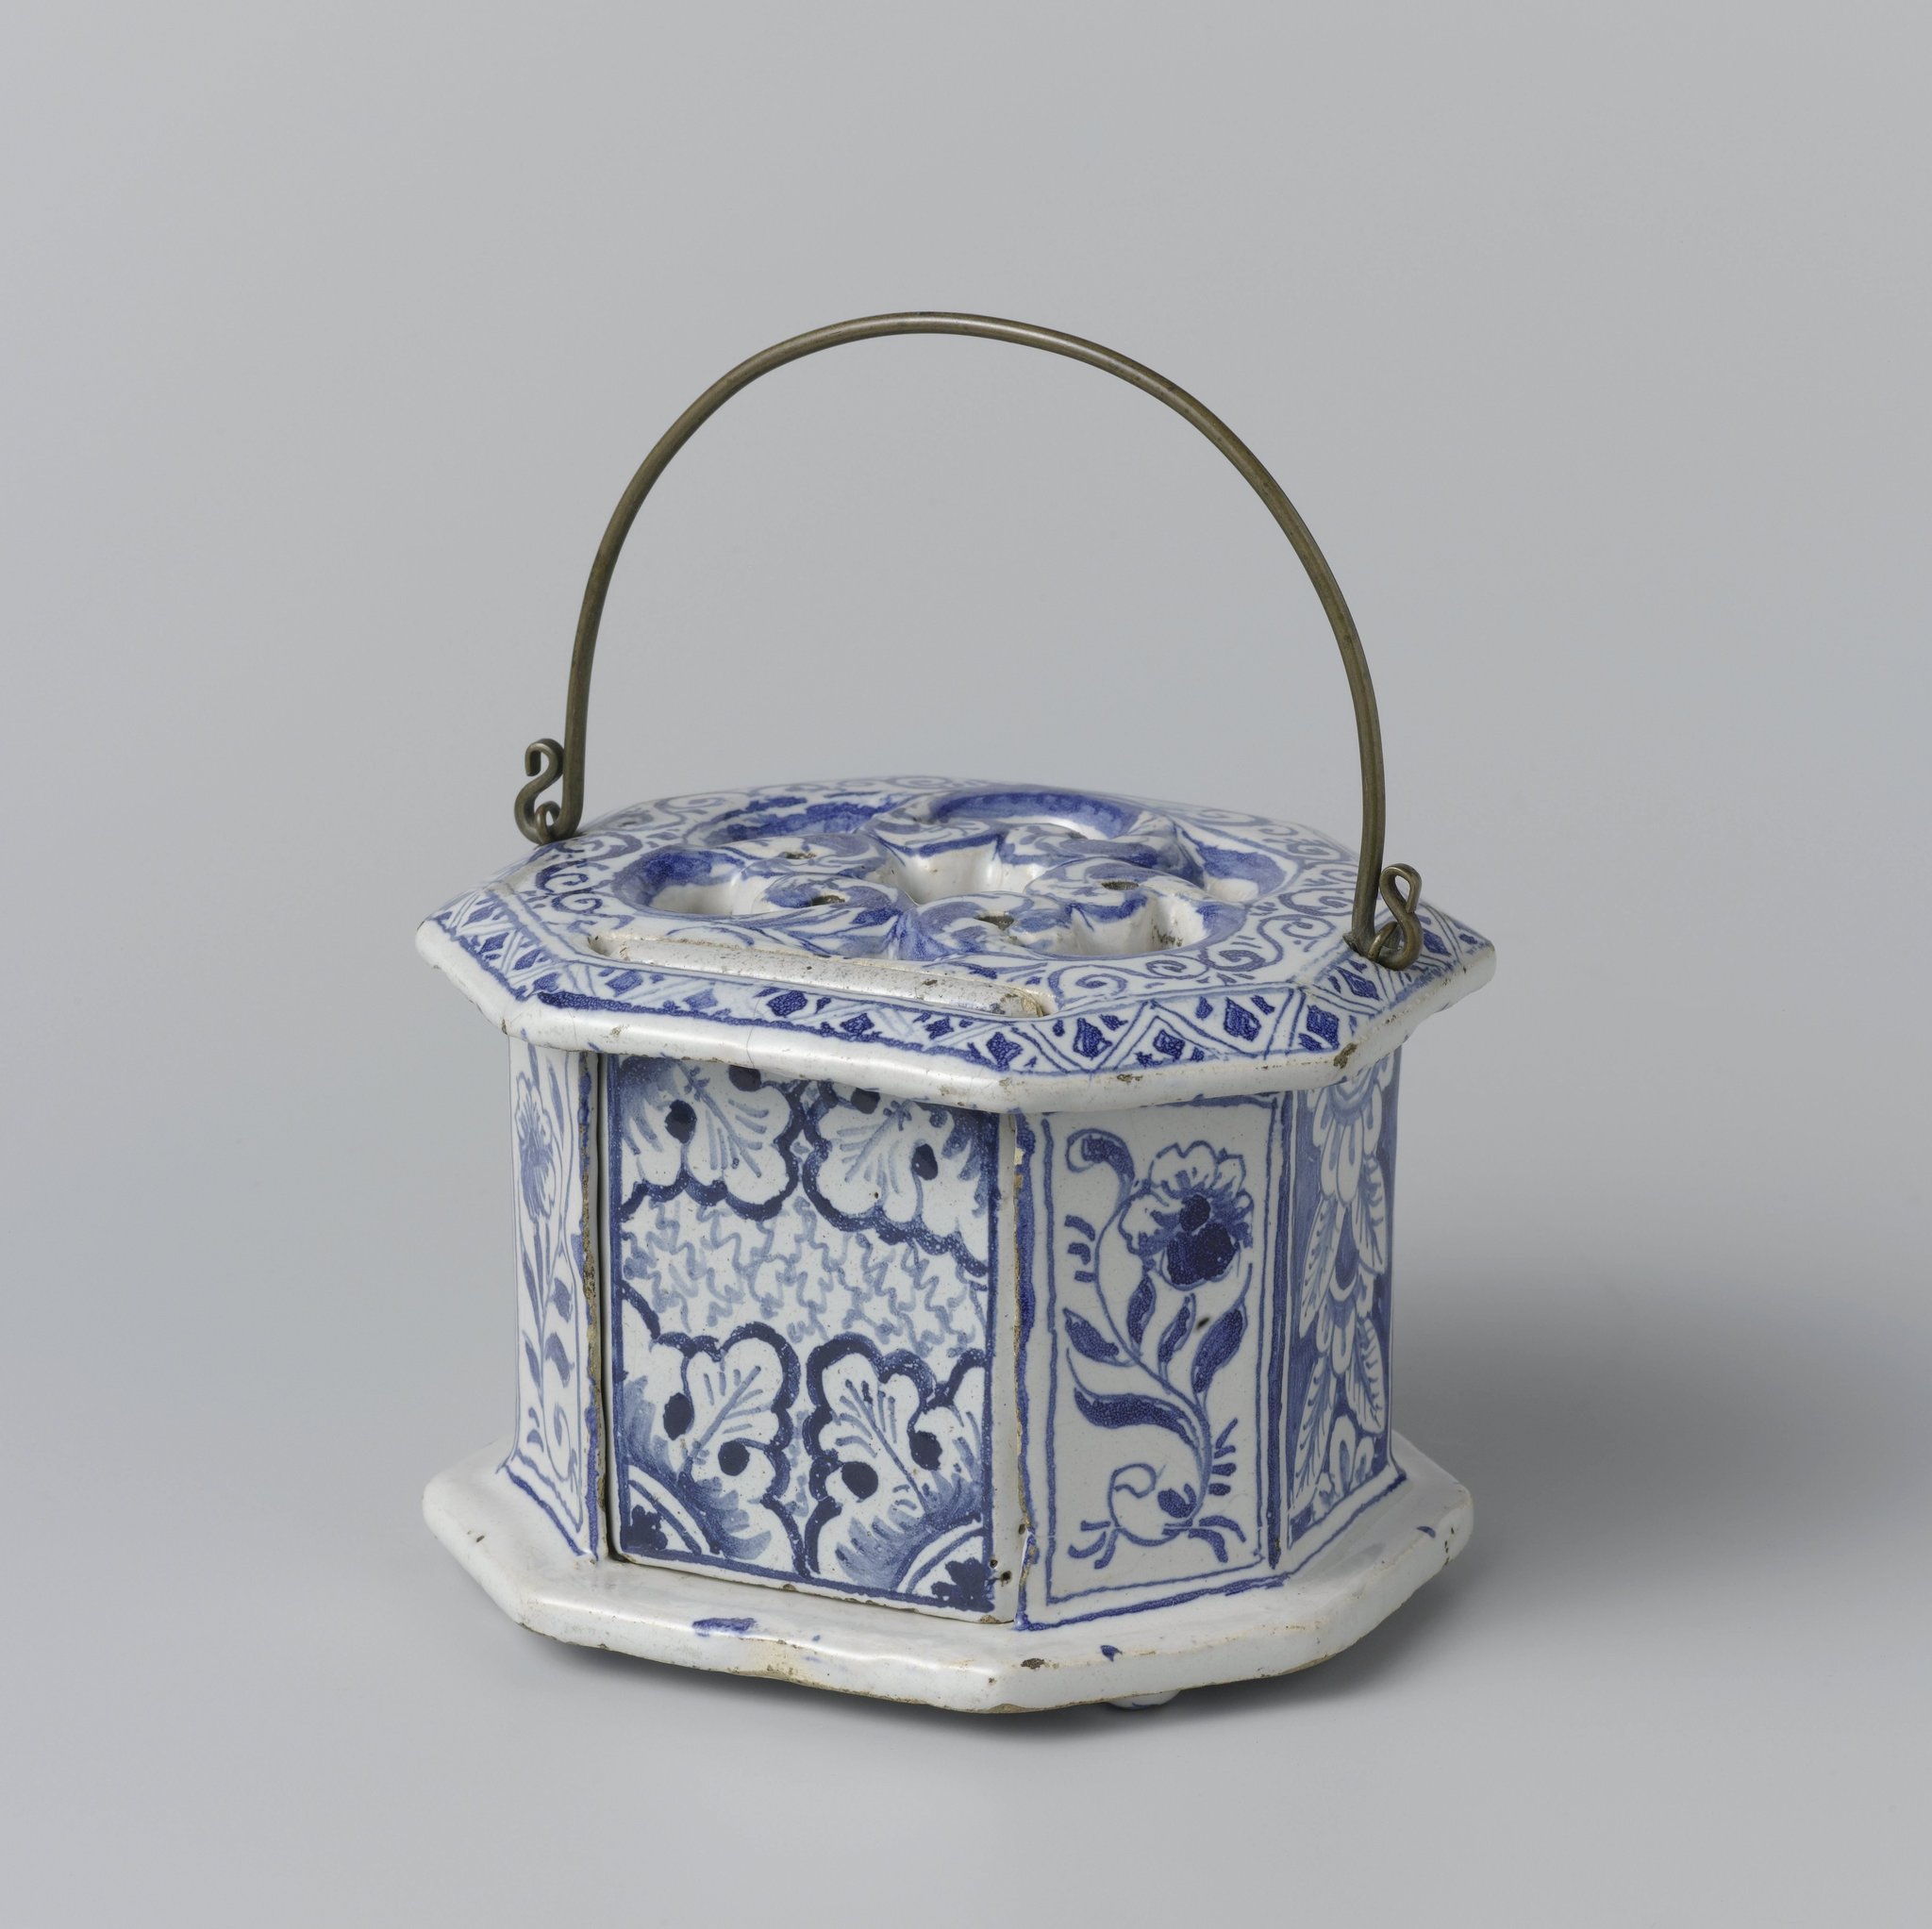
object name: voetstoof, stoof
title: Foot warmer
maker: Anonymous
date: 1760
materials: earthenware, glaze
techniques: painted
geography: makkum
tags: flowers ~ ornament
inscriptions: date: ‘1760’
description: Achtkantige stoof van blauw beschilderde faience, met een schuif en een koperen hengsel. In de stoof staat een test (BK-NM-4001-1). De stoof staat op vier poten en op de onderzijde van de stoof is een rivierlandschap geschilderd met boten, een huis en een toren. De zijwanden van de stoof zijn beschilderd met bloemen. De test is gedateerd: 1760.